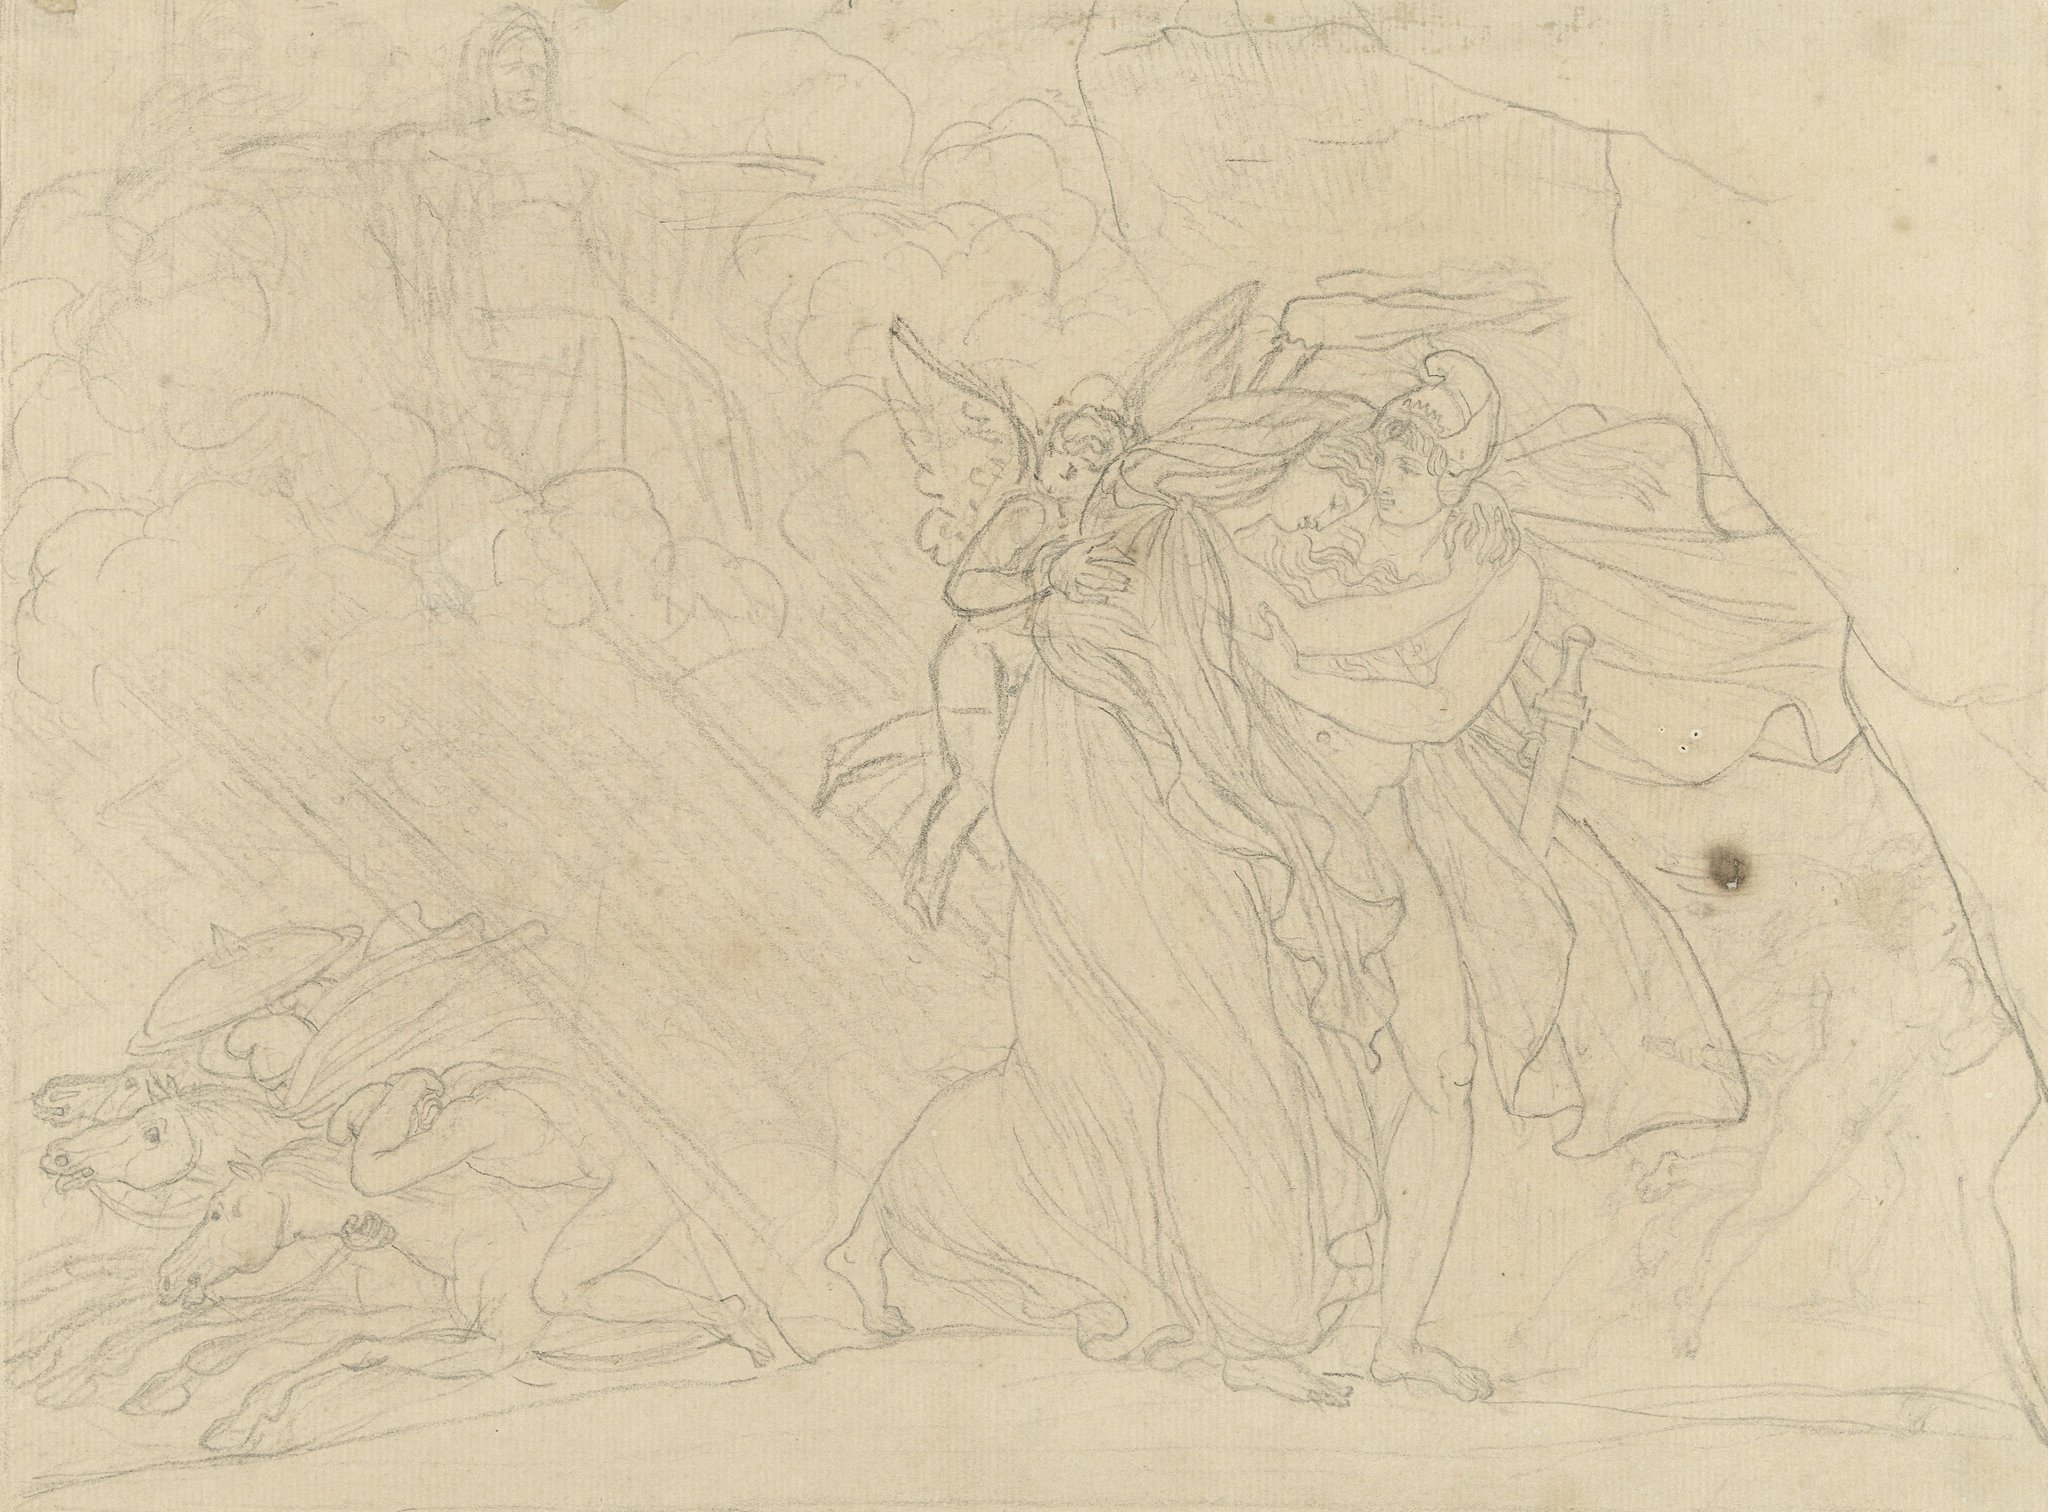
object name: design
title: Vlucht van Dido en Aeneas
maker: anne-louis girodet-trioson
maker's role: draughtsman, painter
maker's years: 1767-1824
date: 1777-1824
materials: chalk, paper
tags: (story of) dido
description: Serie incompleet: 4 ontwerptekeningen in RPK.